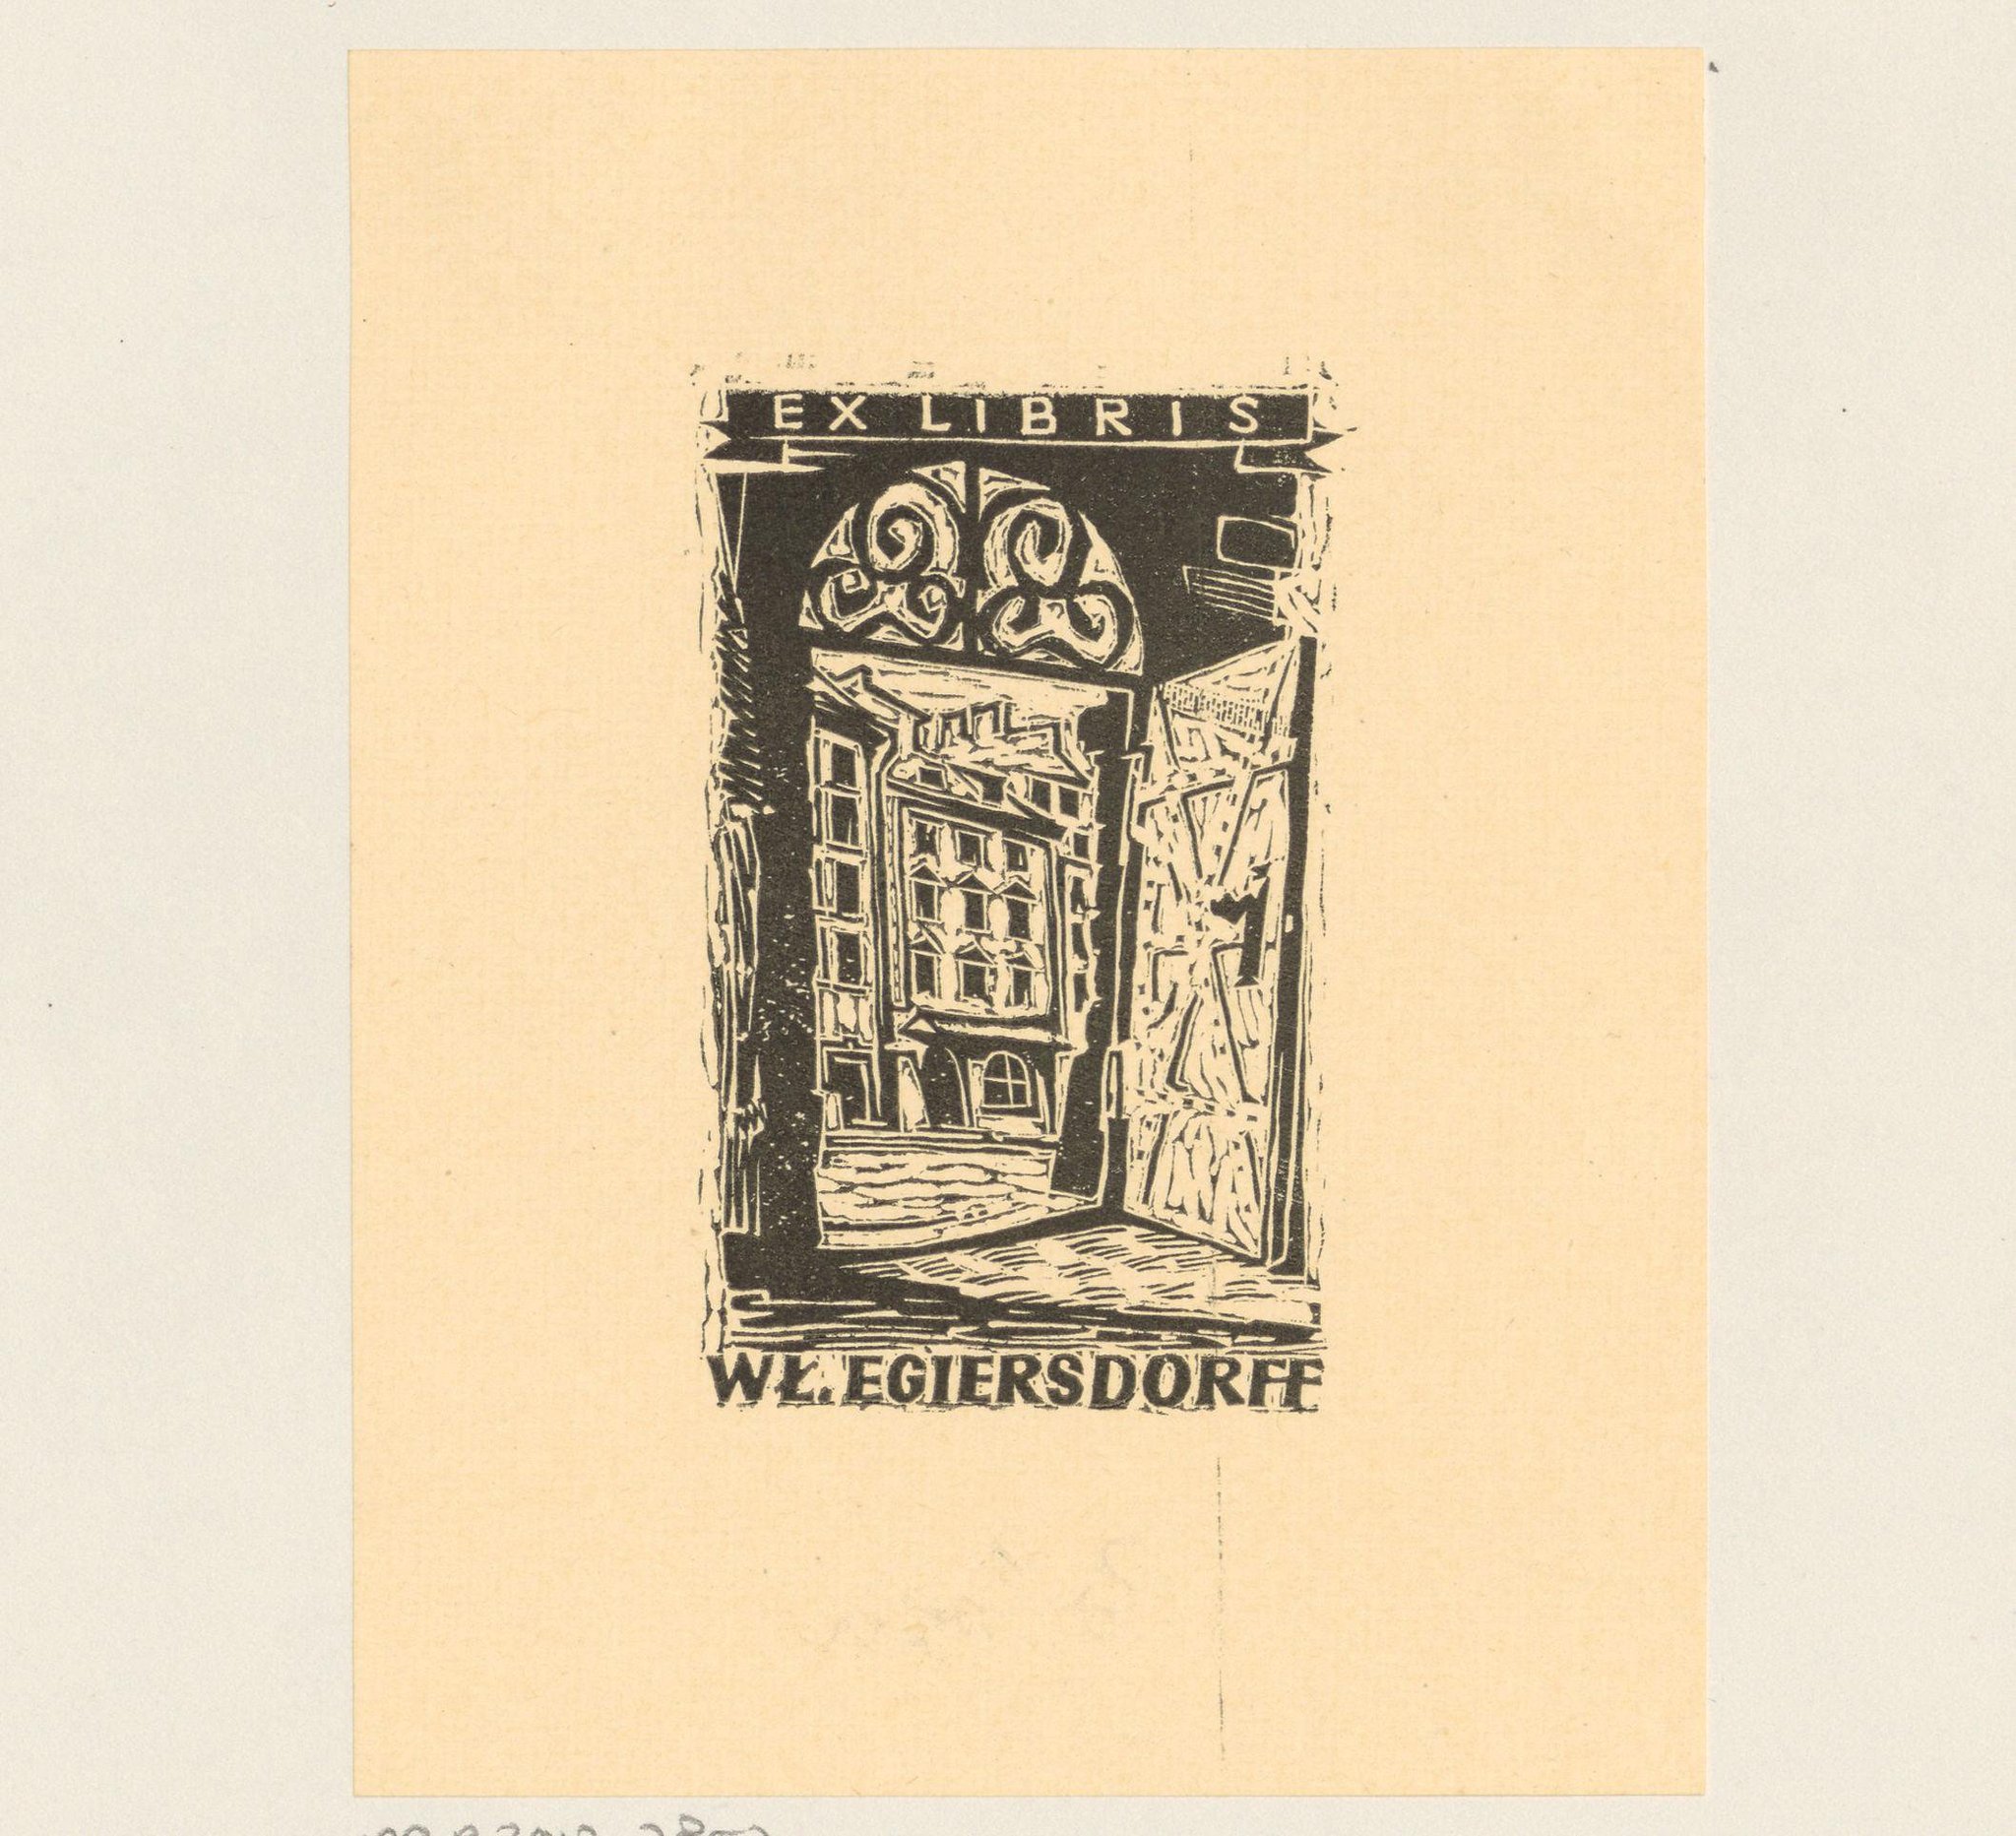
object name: bookplate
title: Ex libris van Włodzimierz Egiersdorff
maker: stanisłas szymański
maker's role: print maker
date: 1911-1977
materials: paper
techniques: woodcut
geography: poland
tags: open door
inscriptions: inscription: ‘Pologne/ bois Szymanski’